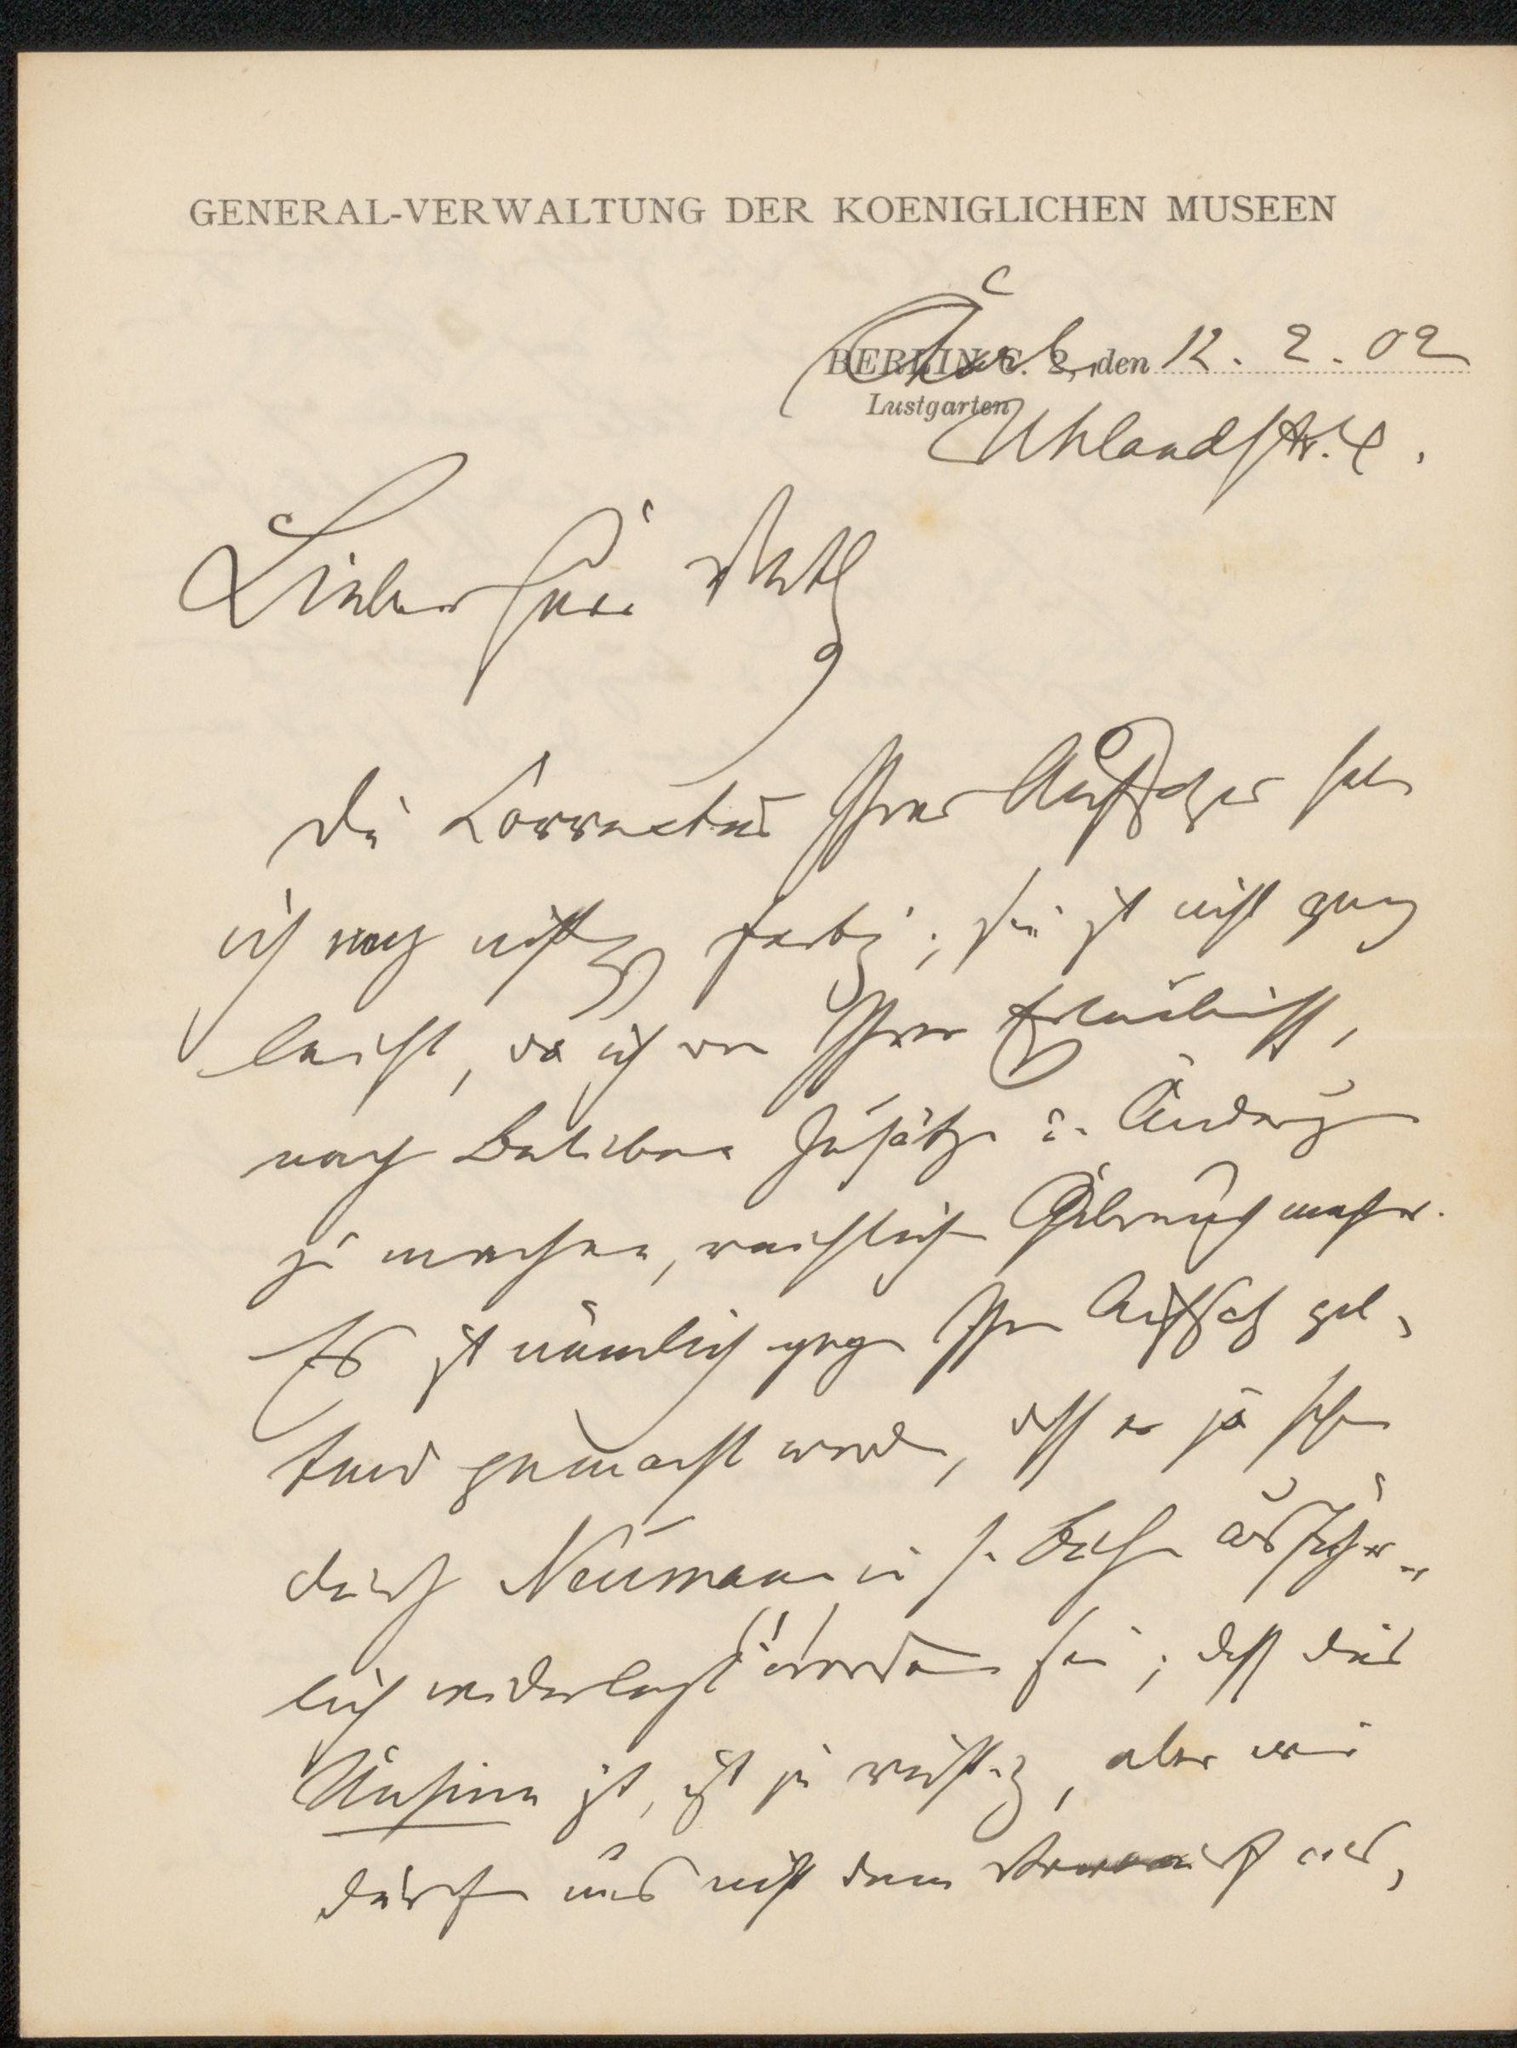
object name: letter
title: Brief aan Jan Veth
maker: wilhelm von bode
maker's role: conservator, kunsthistoricus, museumdirecteur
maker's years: 1845-1929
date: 1902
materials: ink, paper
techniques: pen, printing, writing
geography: berlin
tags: dordrecht, amsterdam, painter, draughtsman, designer, jan veth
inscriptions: watermark, collector's mark: ‘RPK’